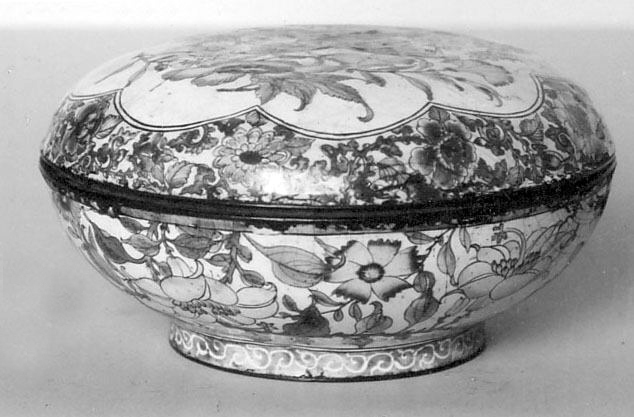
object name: box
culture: chinese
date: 1736-1795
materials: enamel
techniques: painting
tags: flowers